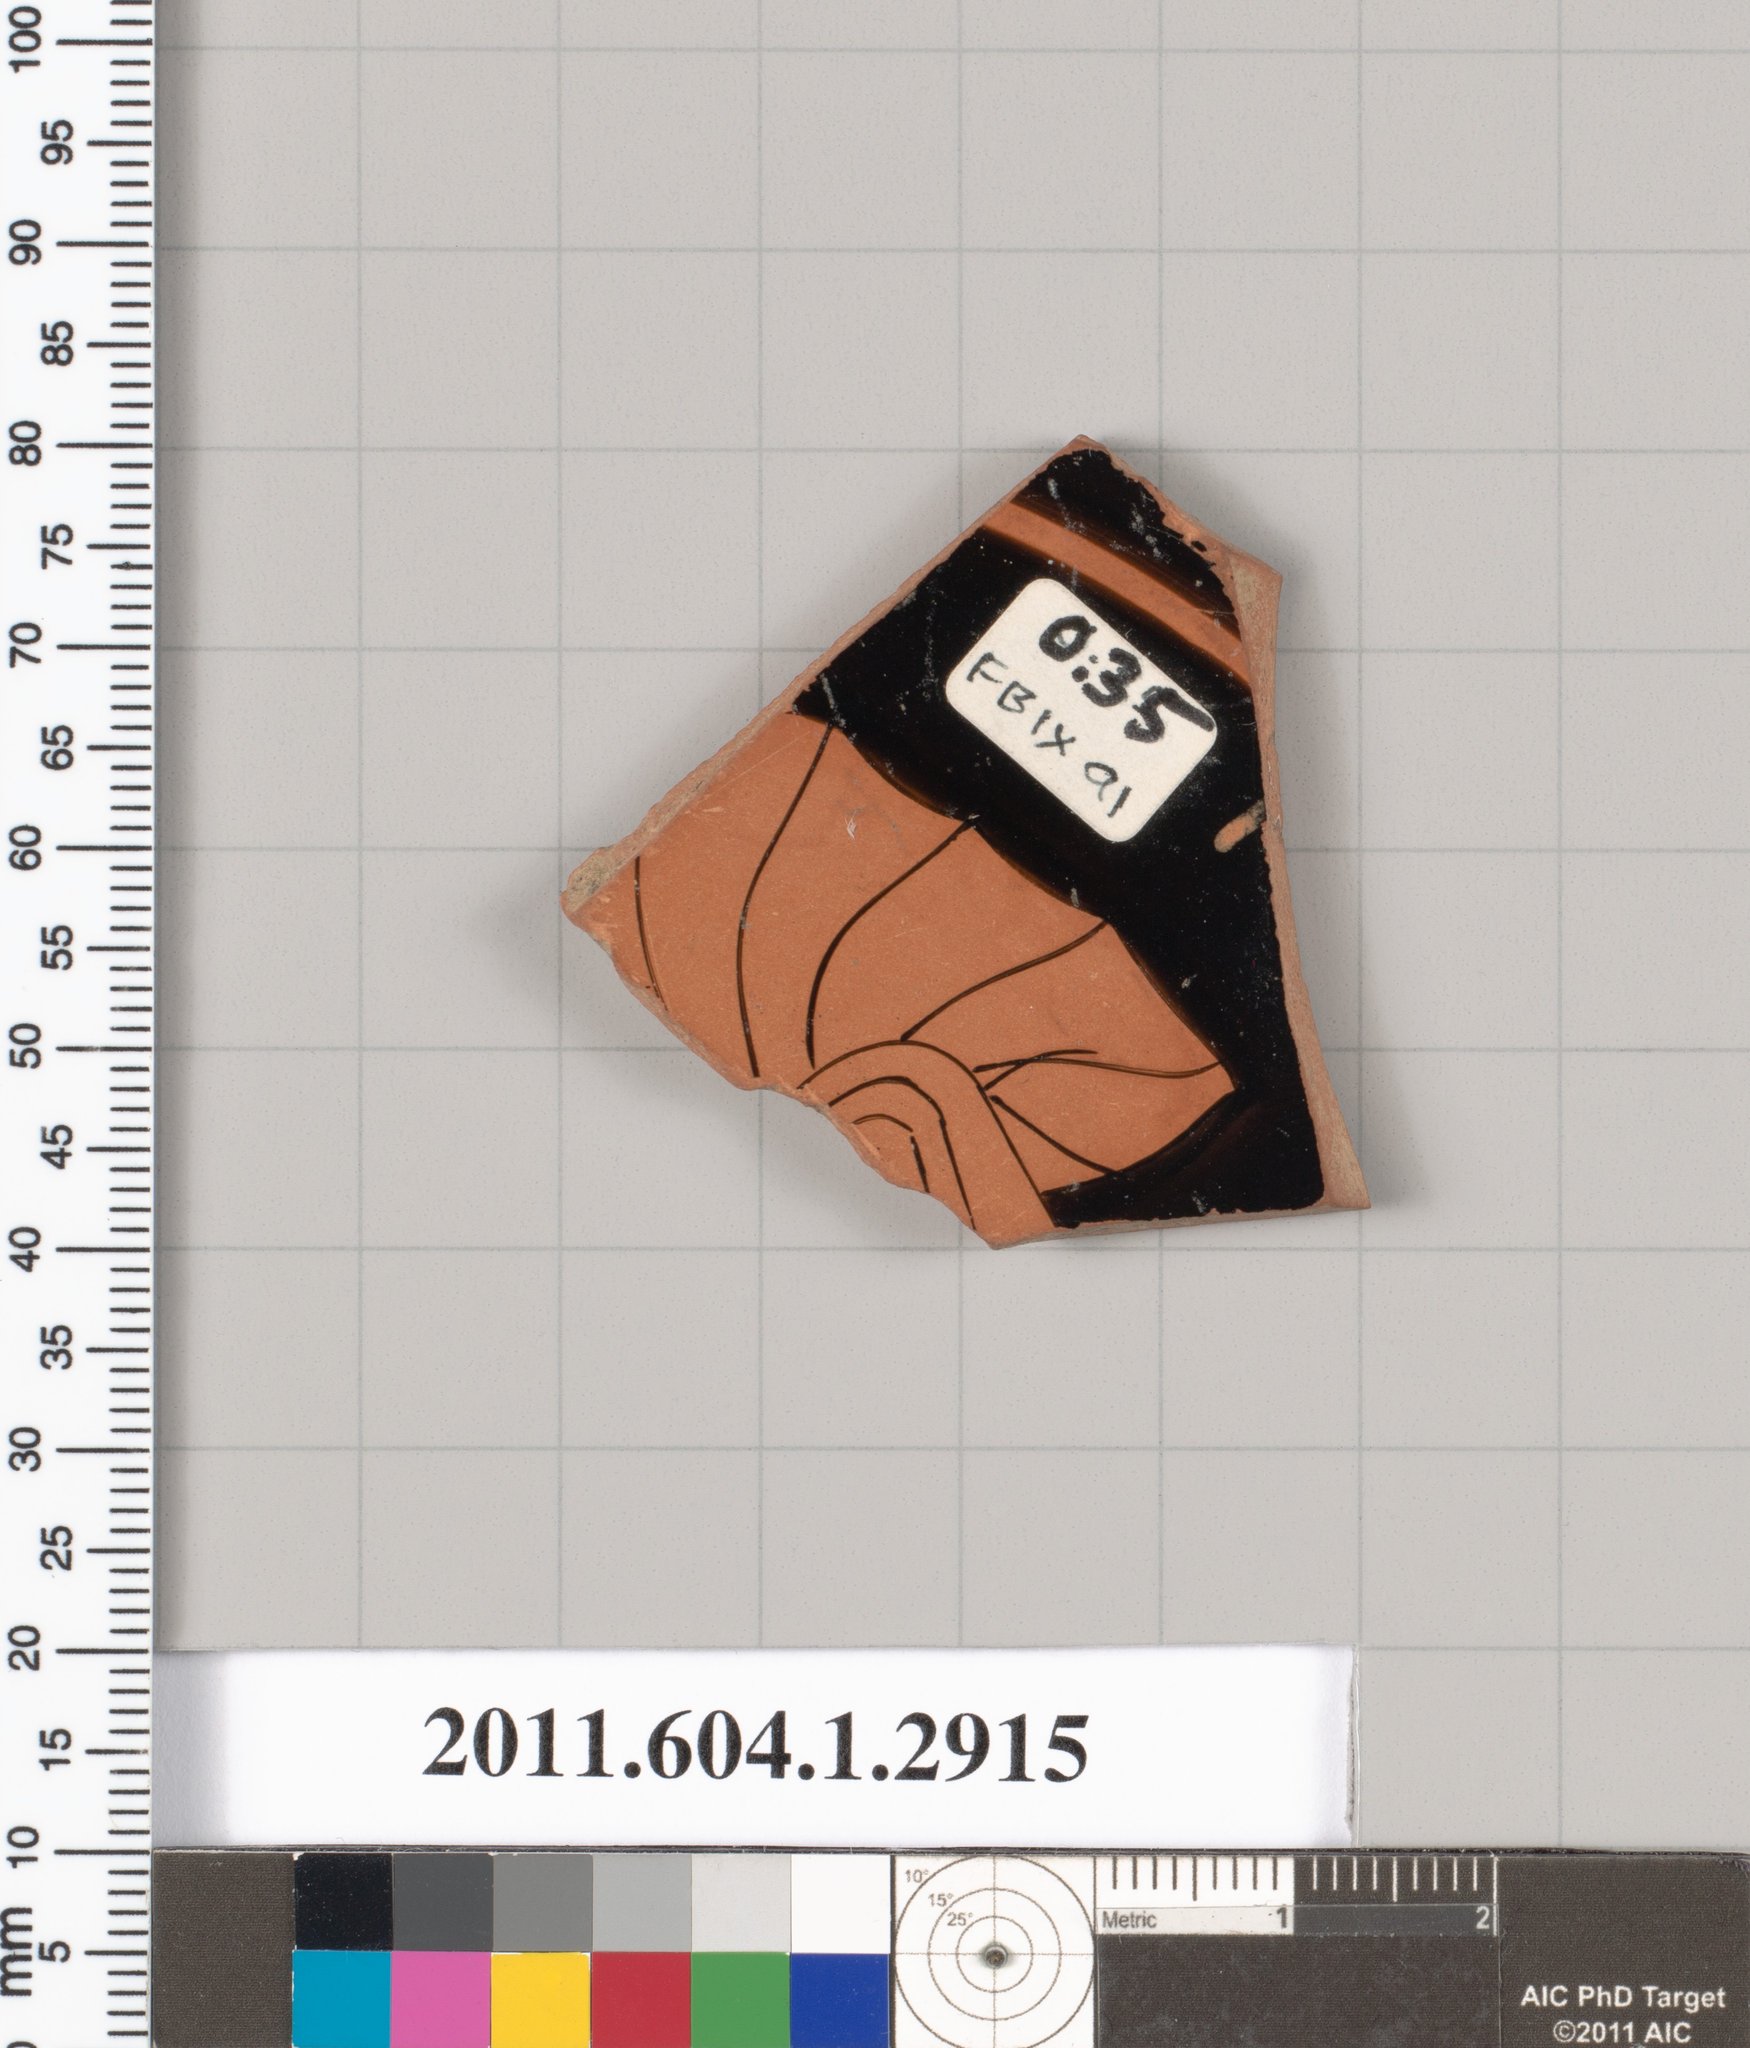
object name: kylix fragment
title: Terracotta fragment of a kylix (drinking cup)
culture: greek, attic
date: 490-480 BCE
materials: terracotta